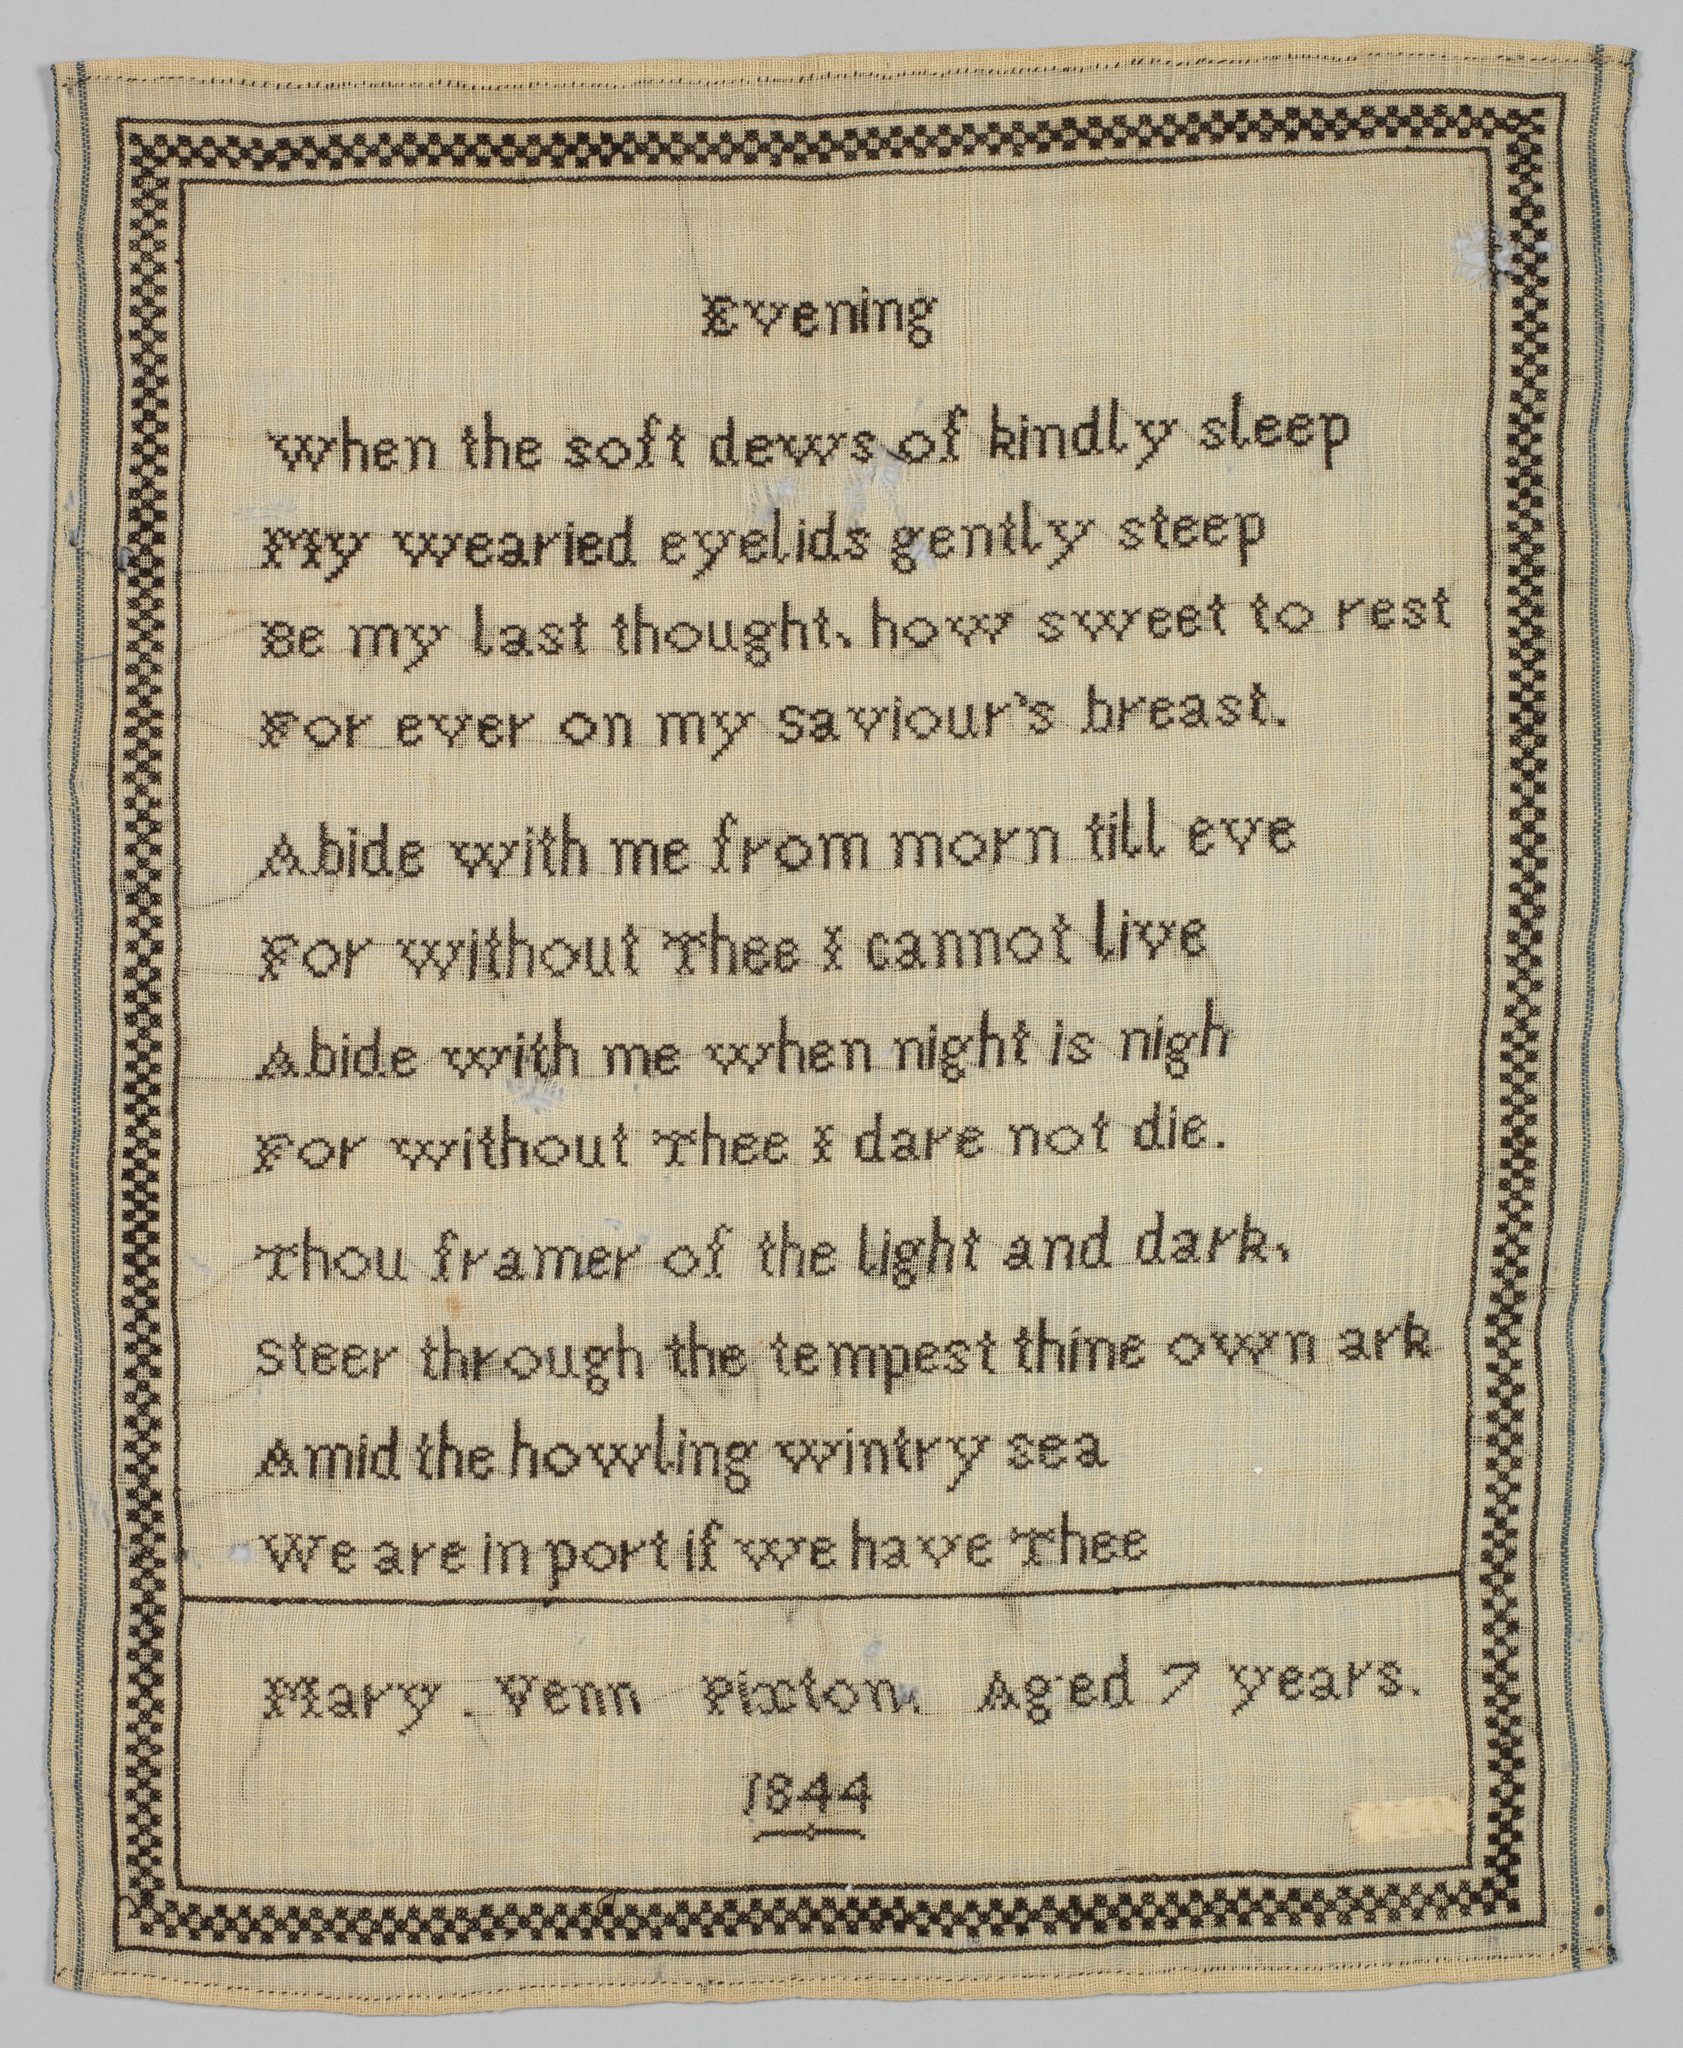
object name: sampler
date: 1844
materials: canvas, silk, wool